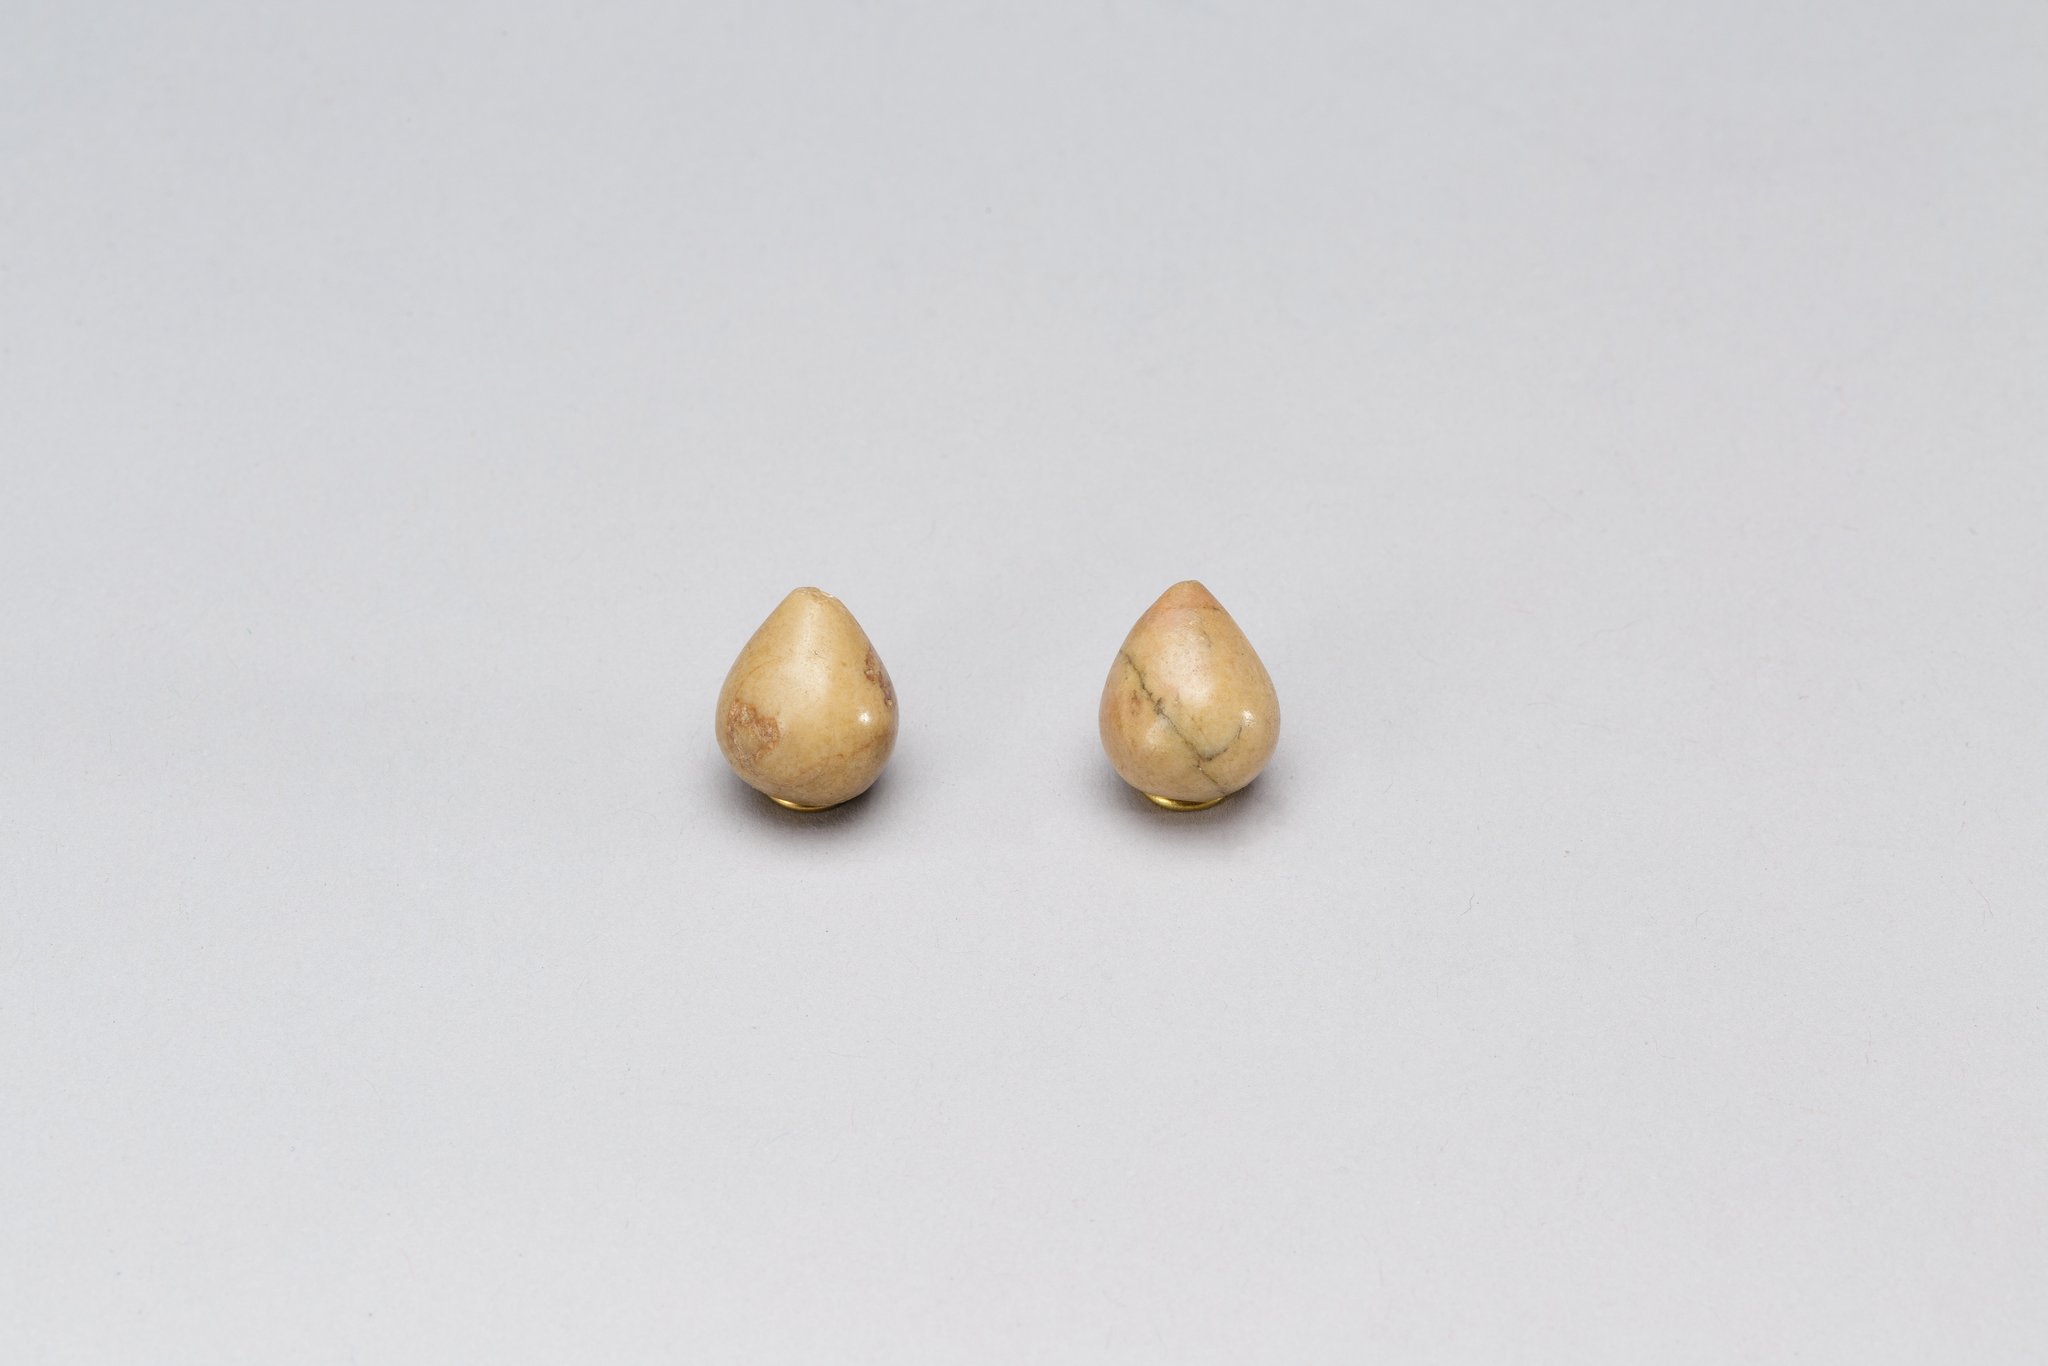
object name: game piece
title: Game Piece (?)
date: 3850-2300 BCE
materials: stone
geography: egypt